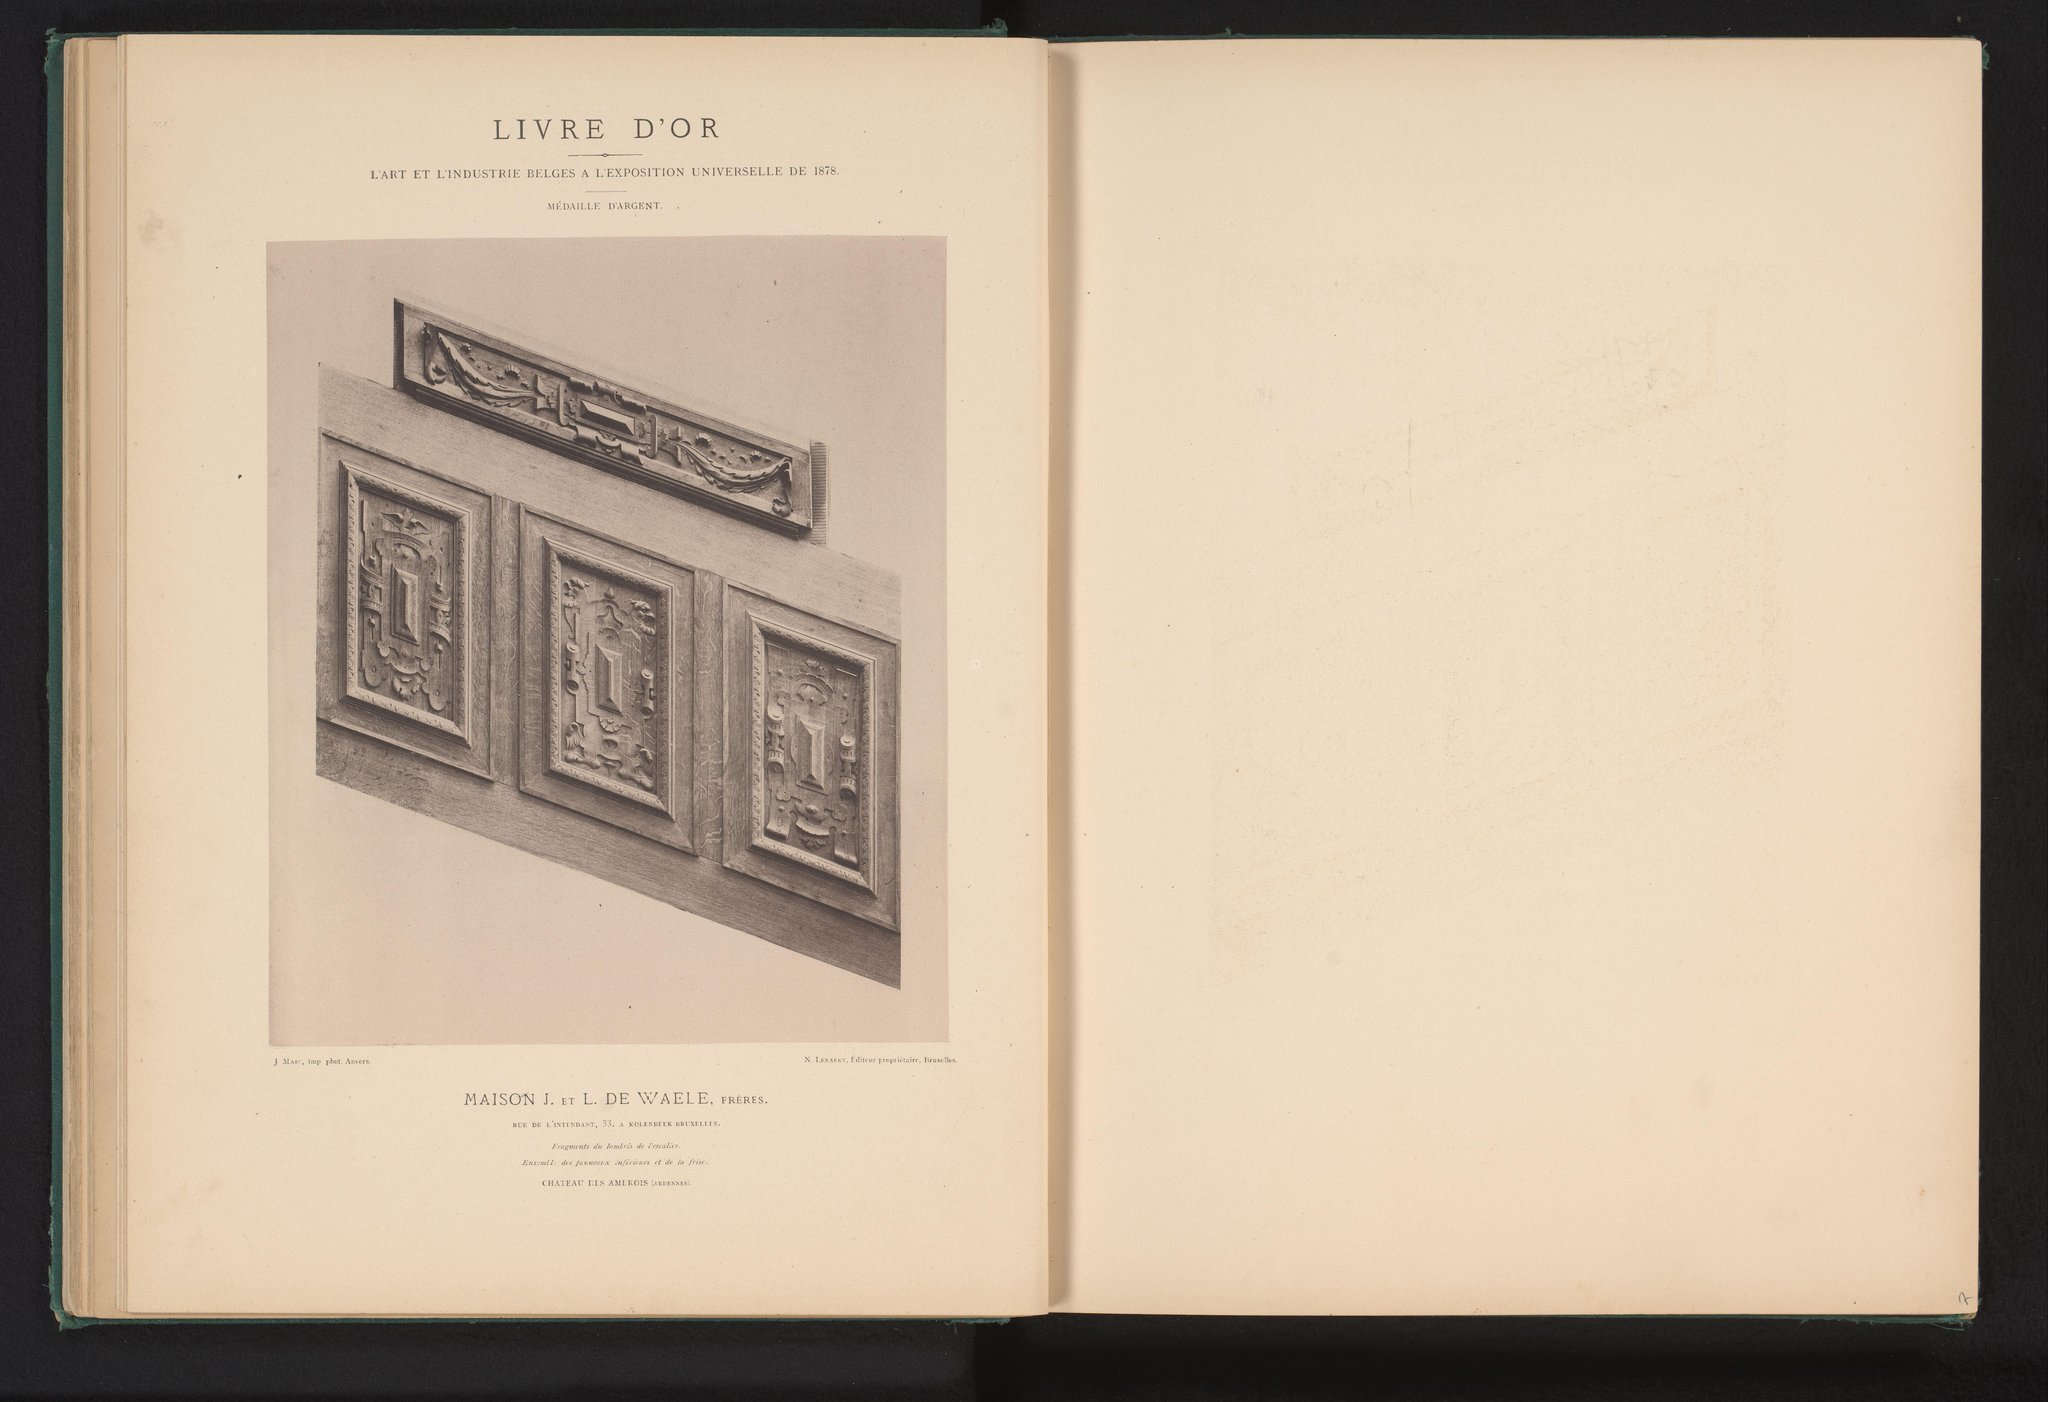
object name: photomechanical print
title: Maison J. et L. de Waele, frères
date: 1874-1879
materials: paper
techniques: photograph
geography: brussels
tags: panelling, sculpture (+ relief ~ sculpture)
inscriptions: inscription: ‘Livre d'or/ L'art et l'industrie Belges a l'exposition universelle de 1878.’, inscription: ‘Rue de l'Intendant, 33, a Molenbeek-Bruxelles’